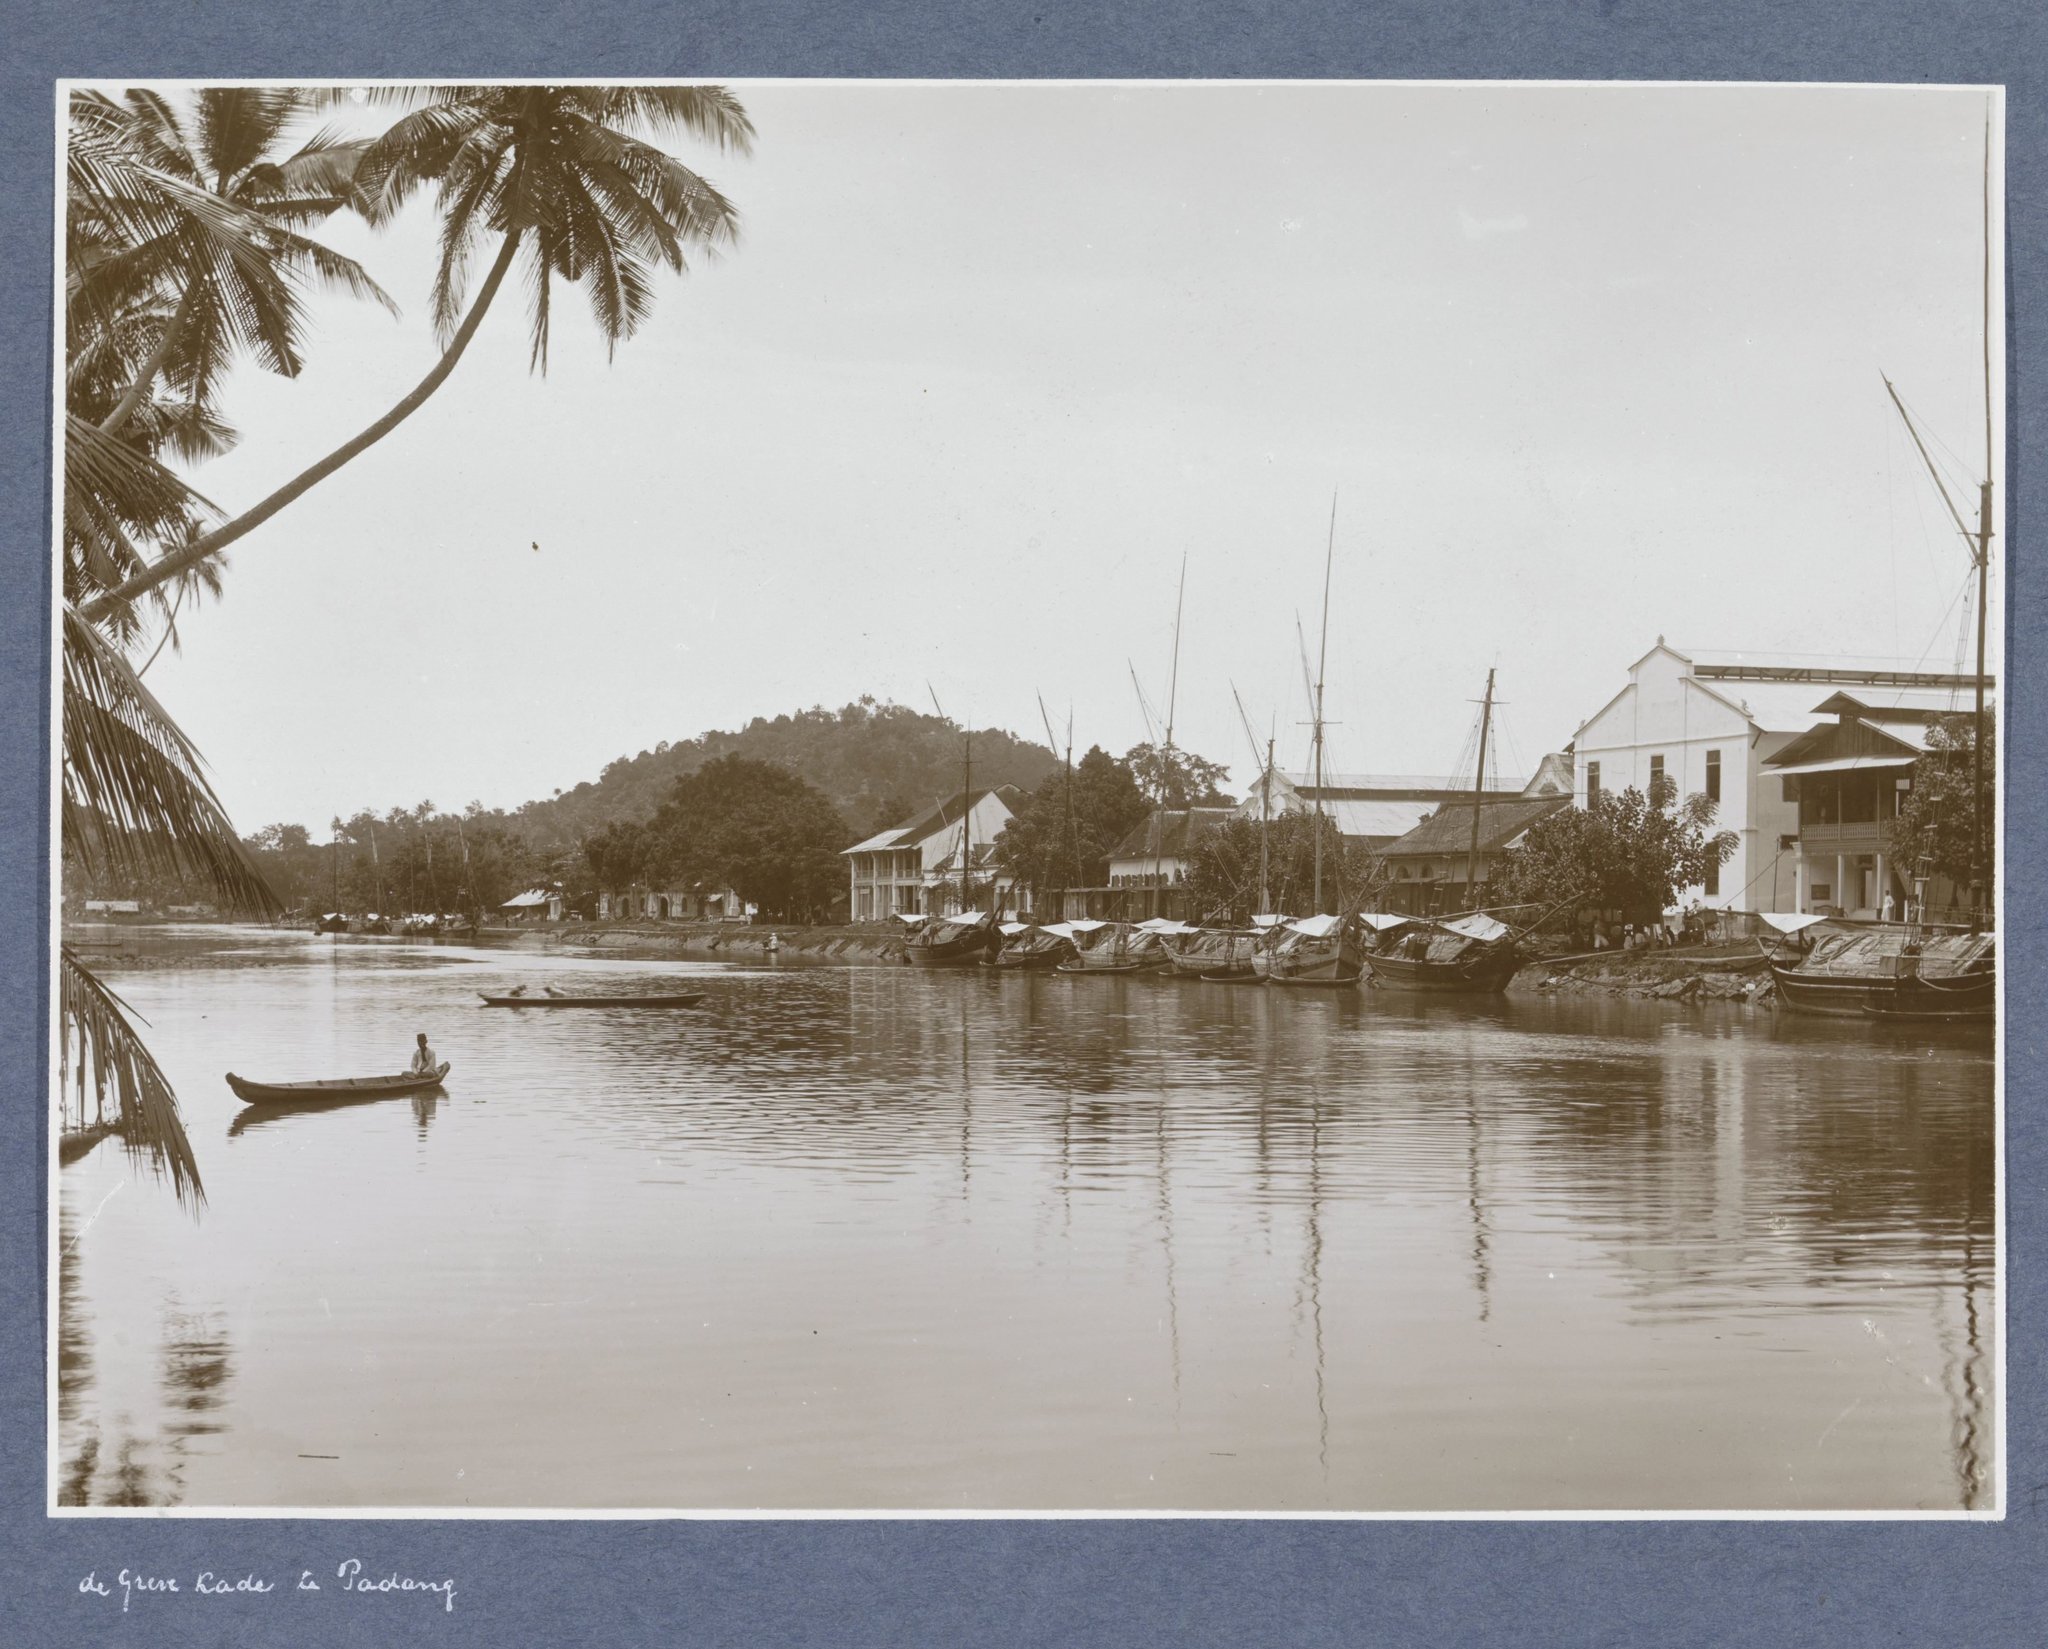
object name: photograph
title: Gezicht op de Grevekade in Padang met schepen, huizen en loodsen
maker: christiaan benjamin nieuwenhuis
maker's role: publisher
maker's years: 1863-1922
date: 1900-1920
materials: paper, photographic support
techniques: gelatin silver print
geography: padang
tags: harbour (+ view ~ vehicle, ship, etc.), river bank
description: Onderdeel van reisalbum met foto's van bedrijvigheid en bezienswaardigheden op Sumatra en Java en van de reis naar en van Nederlands-Indië.